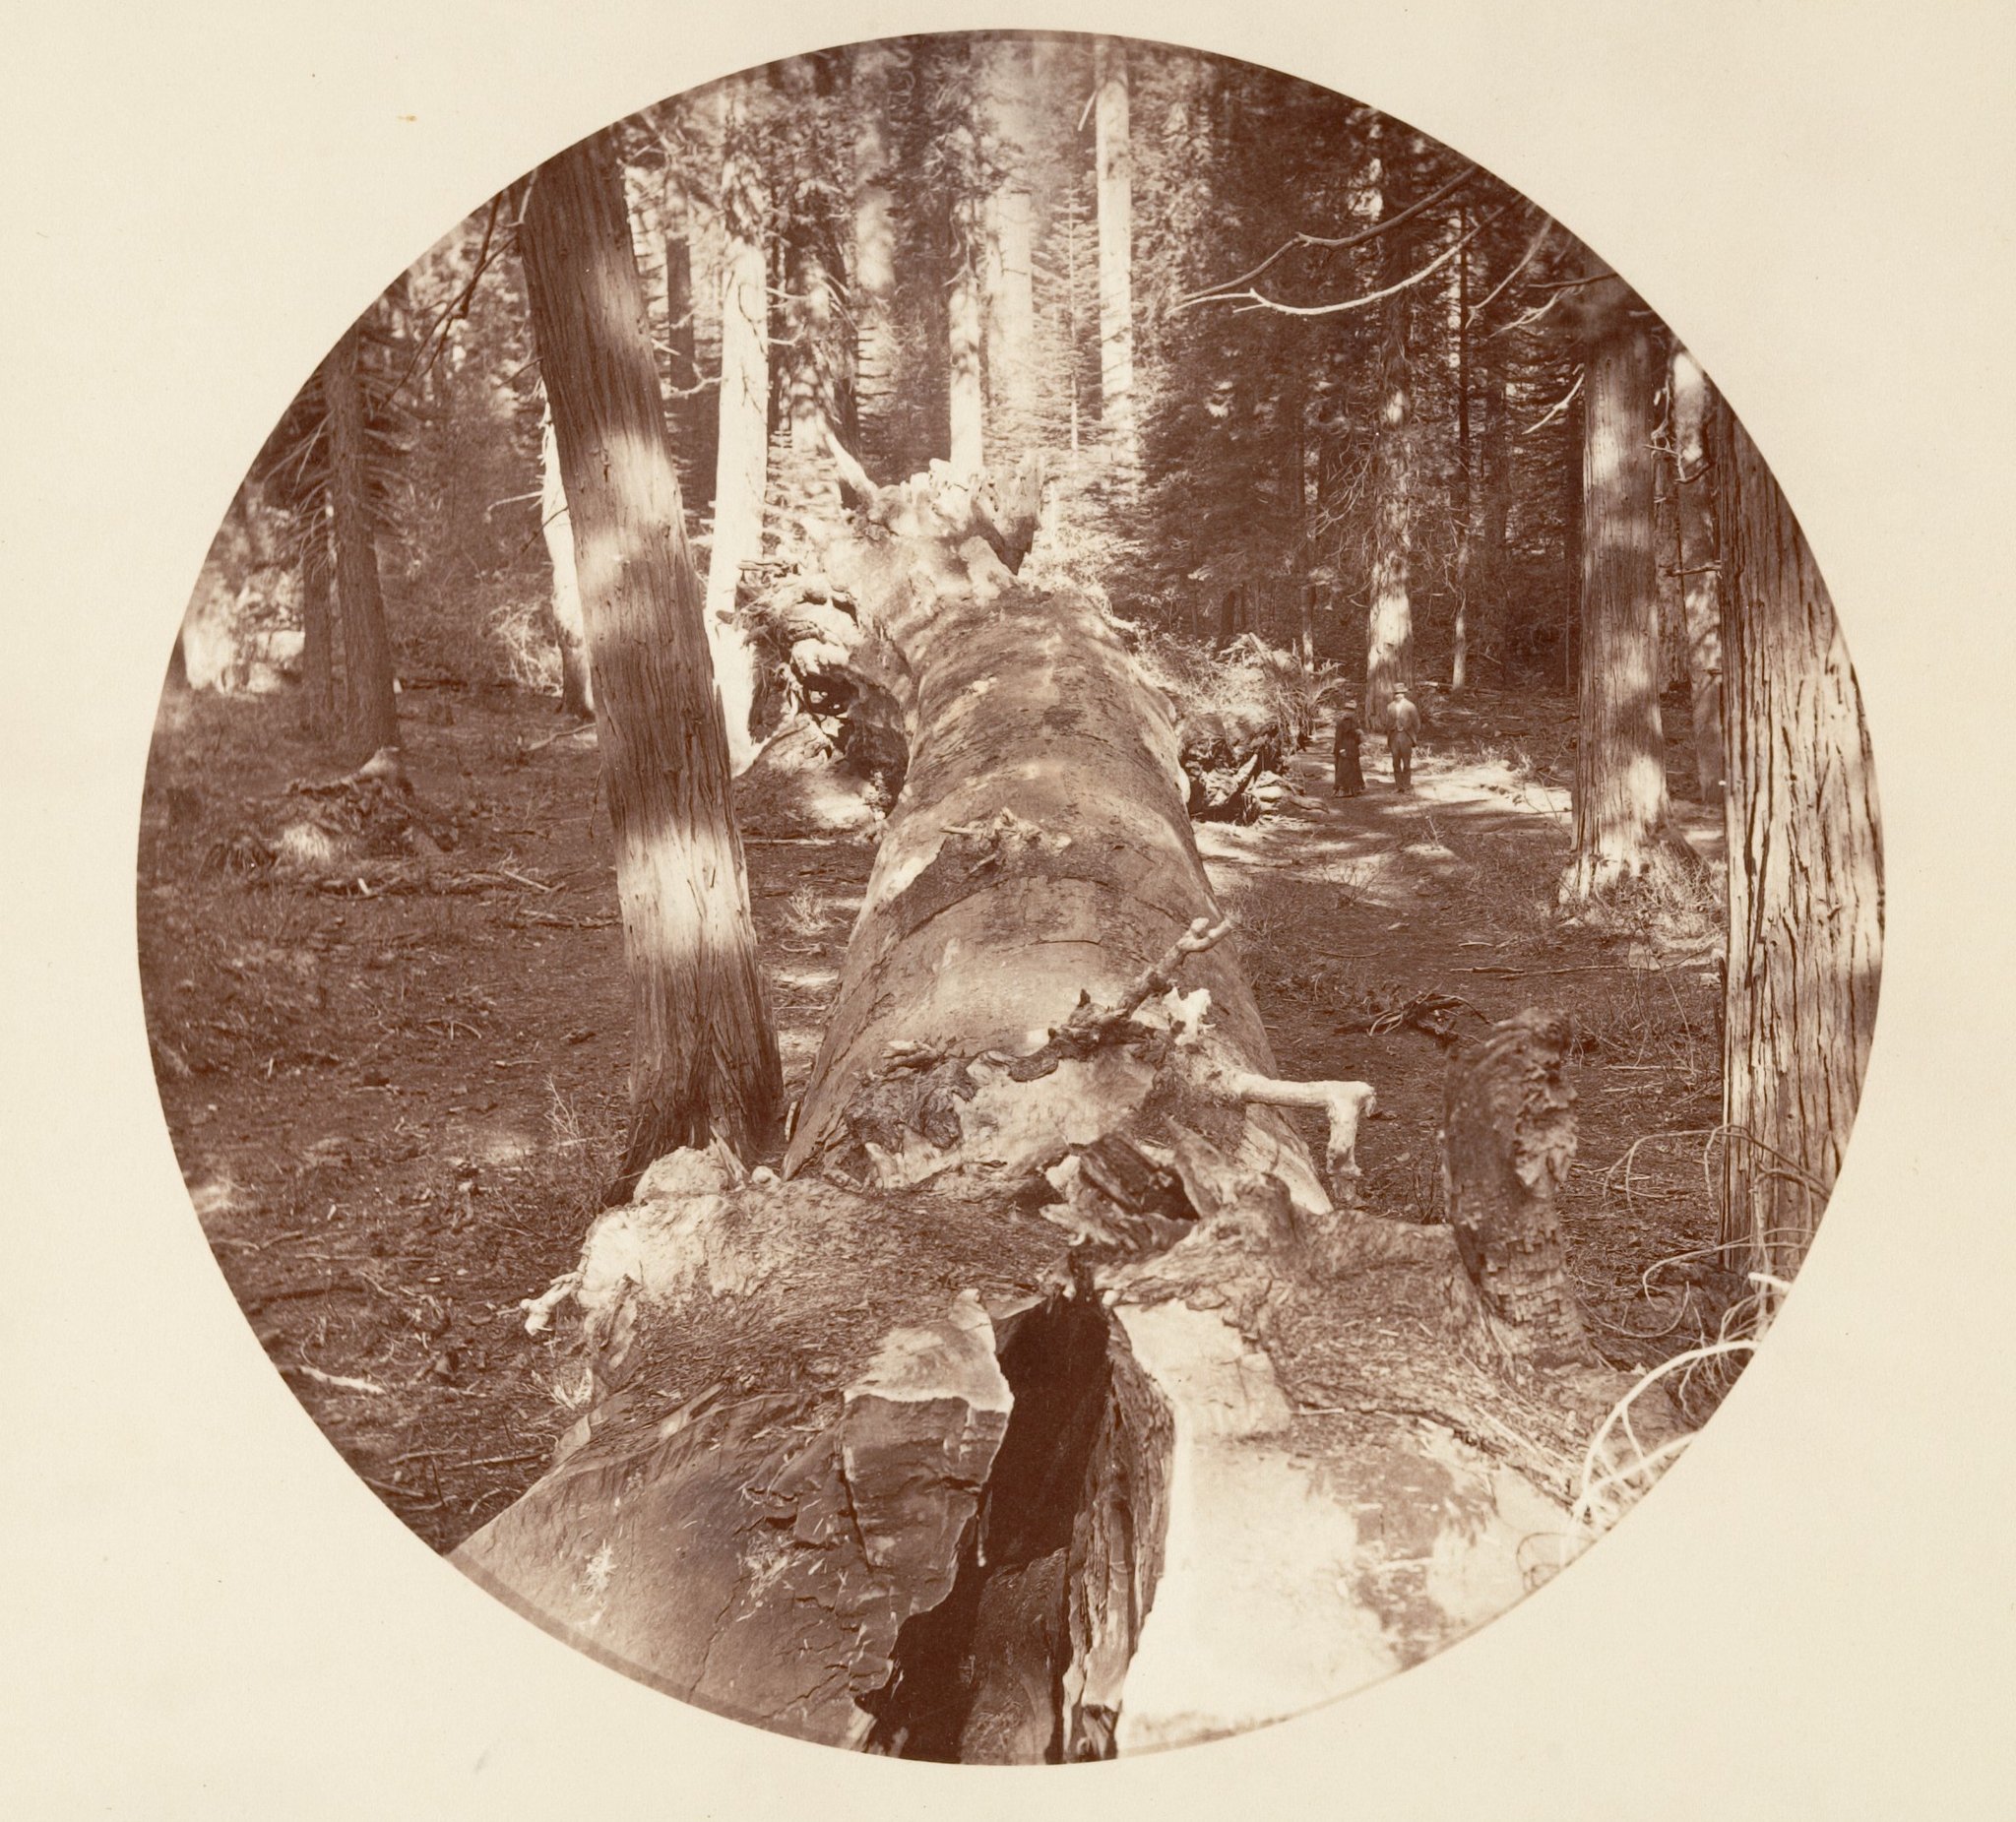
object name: photograph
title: [Yosemite National Park, California]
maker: carleton e. watkins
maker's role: artist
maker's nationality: american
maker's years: 1829-1916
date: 1878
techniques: albumen silver print, glass negative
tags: forests,trees